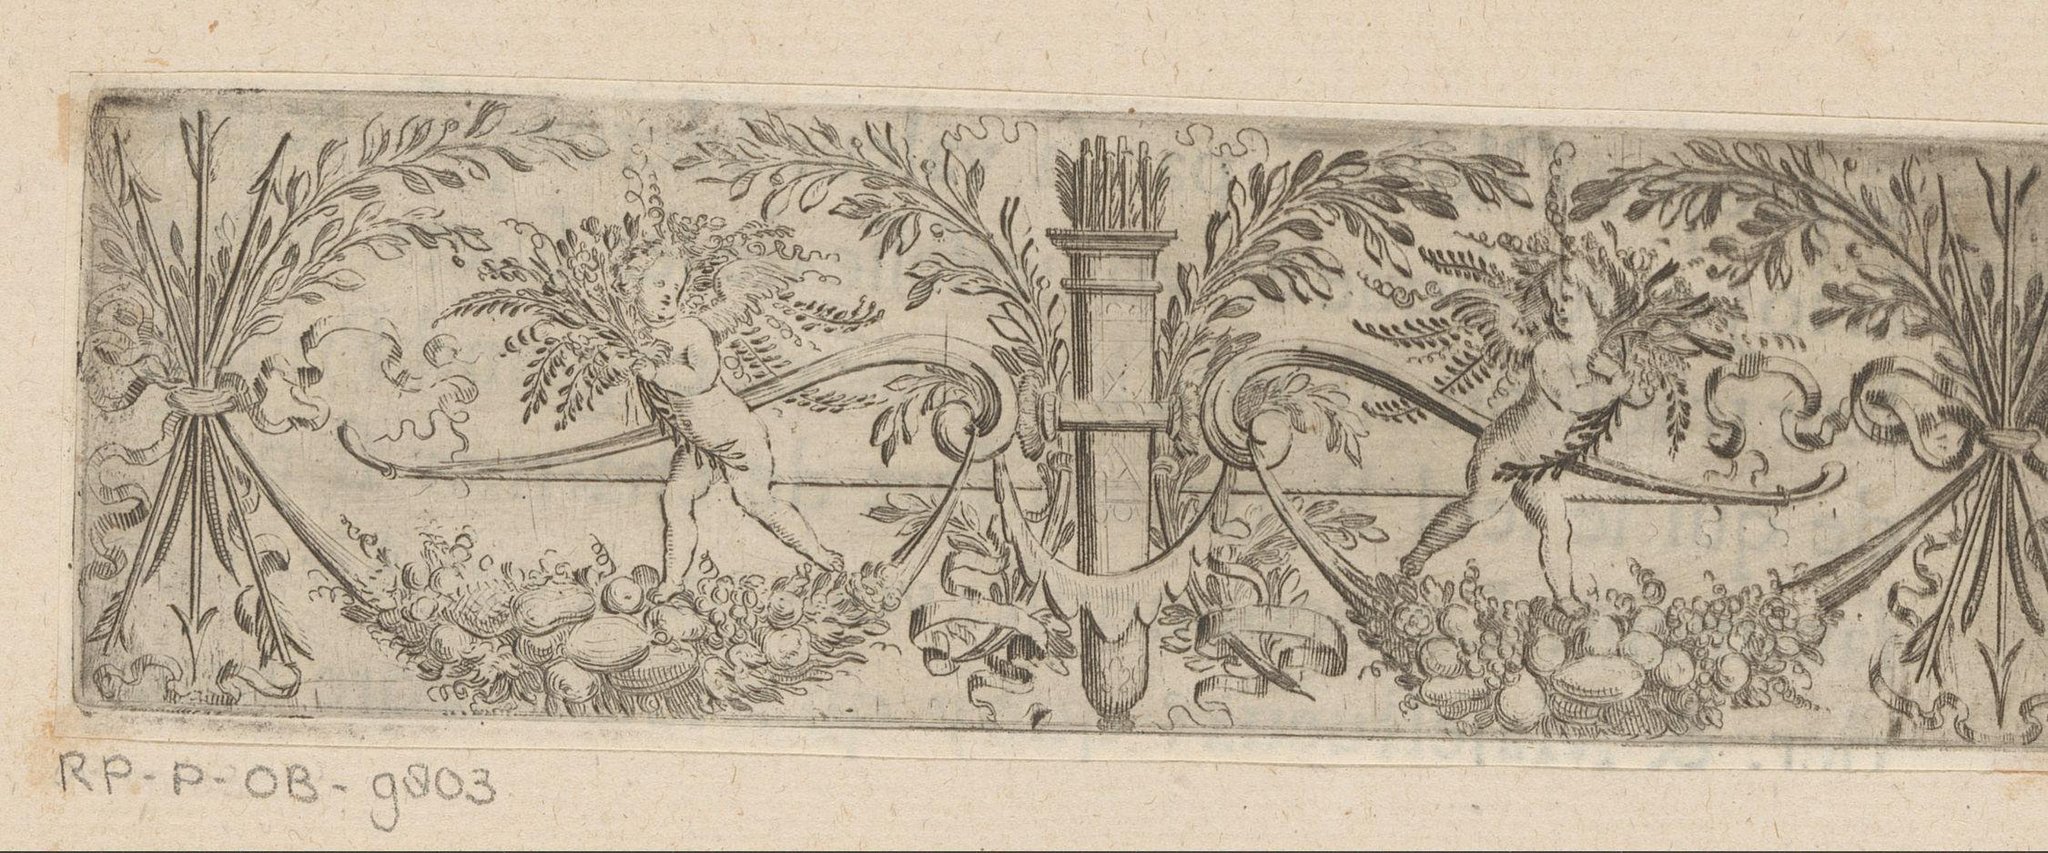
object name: print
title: Monumenten en feestelijkheden tijdens intocht van Karel IV in Nancy, 1641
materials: paper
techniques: etching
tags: quiver, ornaments ~ art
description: Prent uit: Bardin, Philippe. Le Triomphe De Son Altesse Charles IIII (...). Nancy: Poirel, Dominique, Charlot Anthoine en Charlot Claude, 1664.